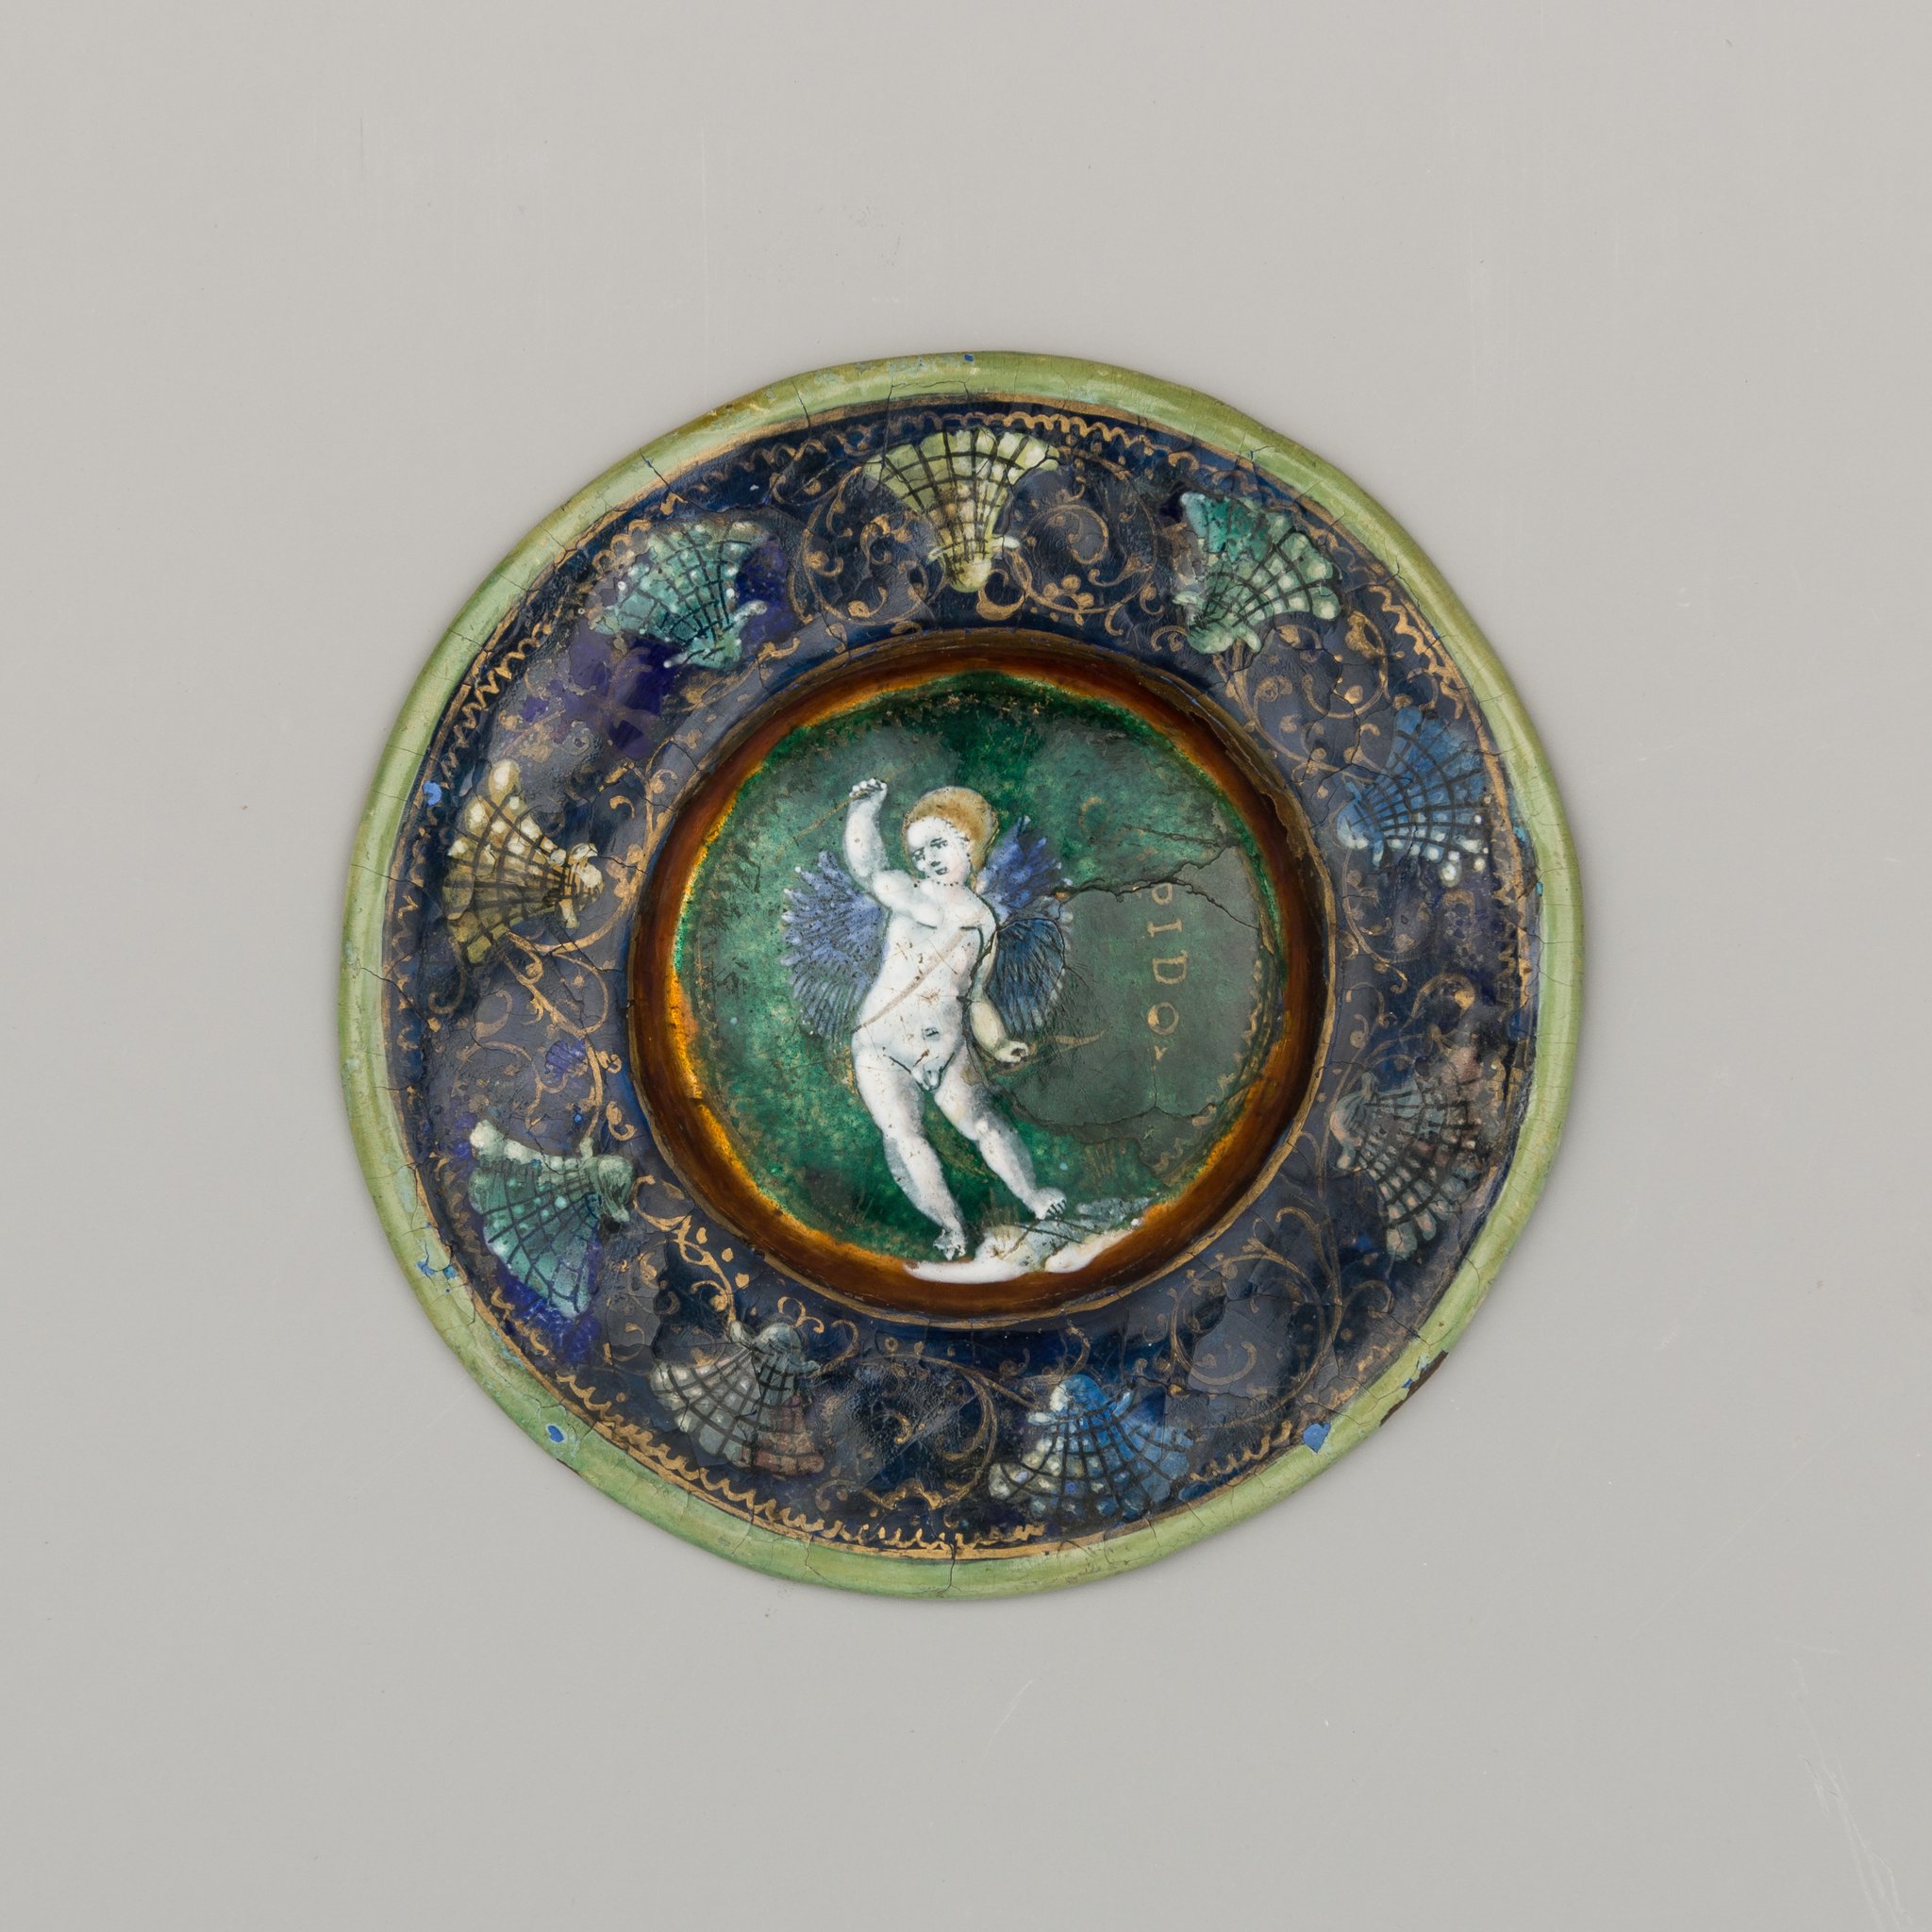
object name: bit bos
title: Bit Boss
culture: french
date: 1501-1600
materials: copper, enamel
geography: france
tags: male nudes